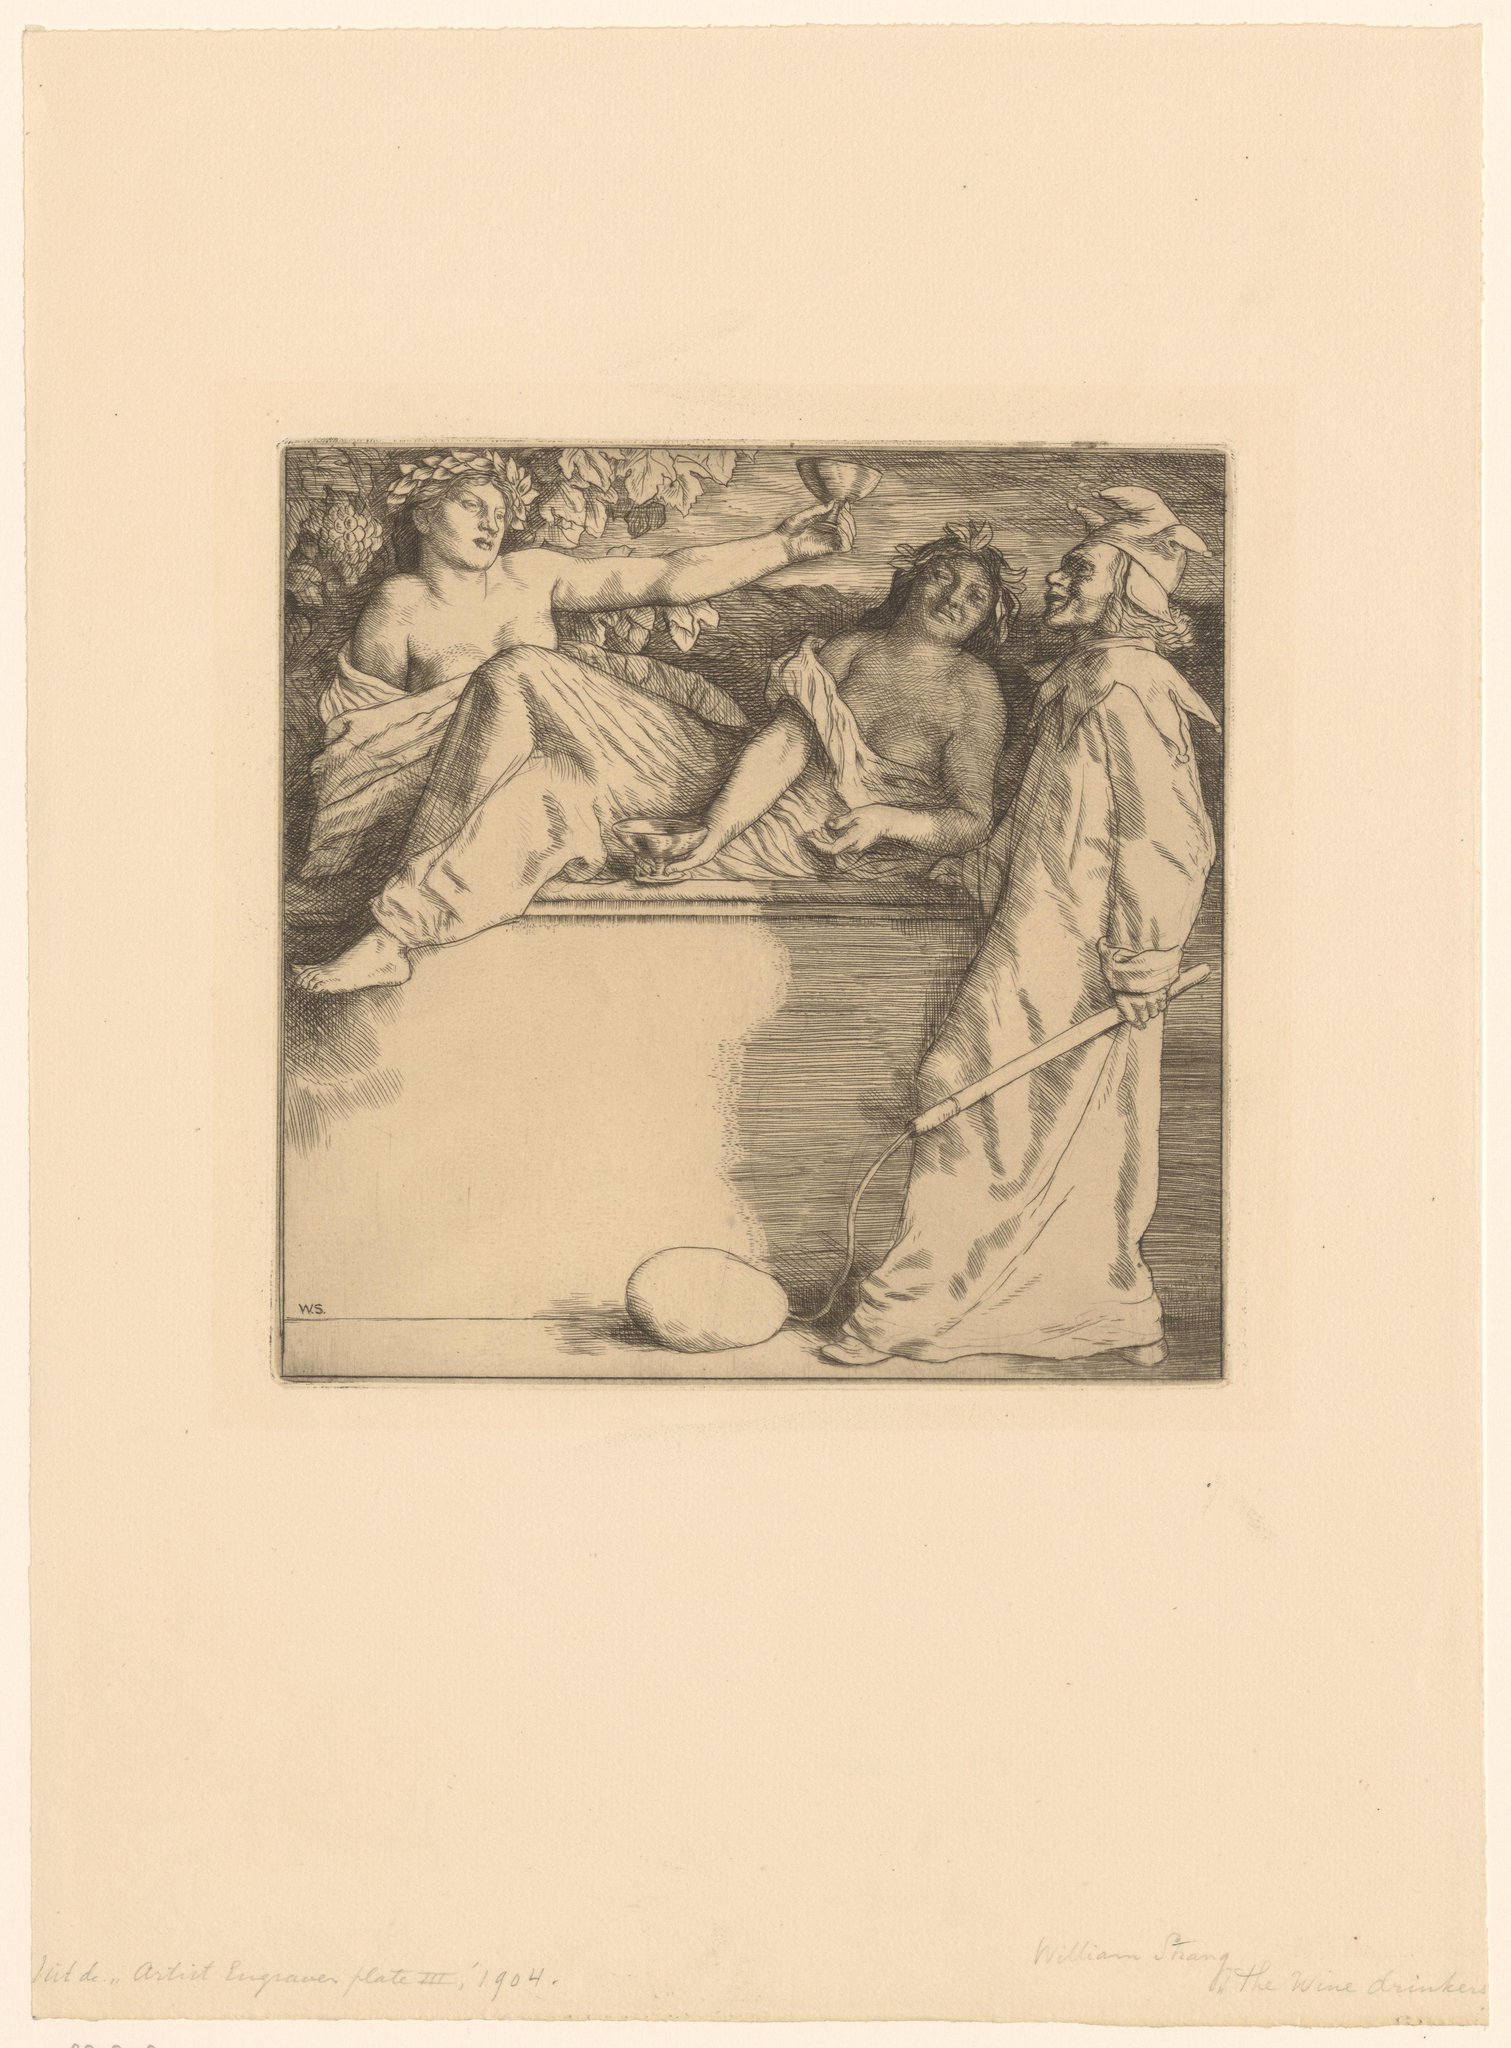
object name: print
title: Wijndrinkers en clown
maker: william strang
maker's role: print maker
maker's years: 1859-1921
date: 1904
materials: paper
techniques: etching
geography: london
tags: drunkenness, glass of wine, clown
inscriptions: collector's mark: Lugt 2228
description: Prent waarschijnlijk uit: The Artist Engraver: A Quarterly Magazine of Original Work, 1904.